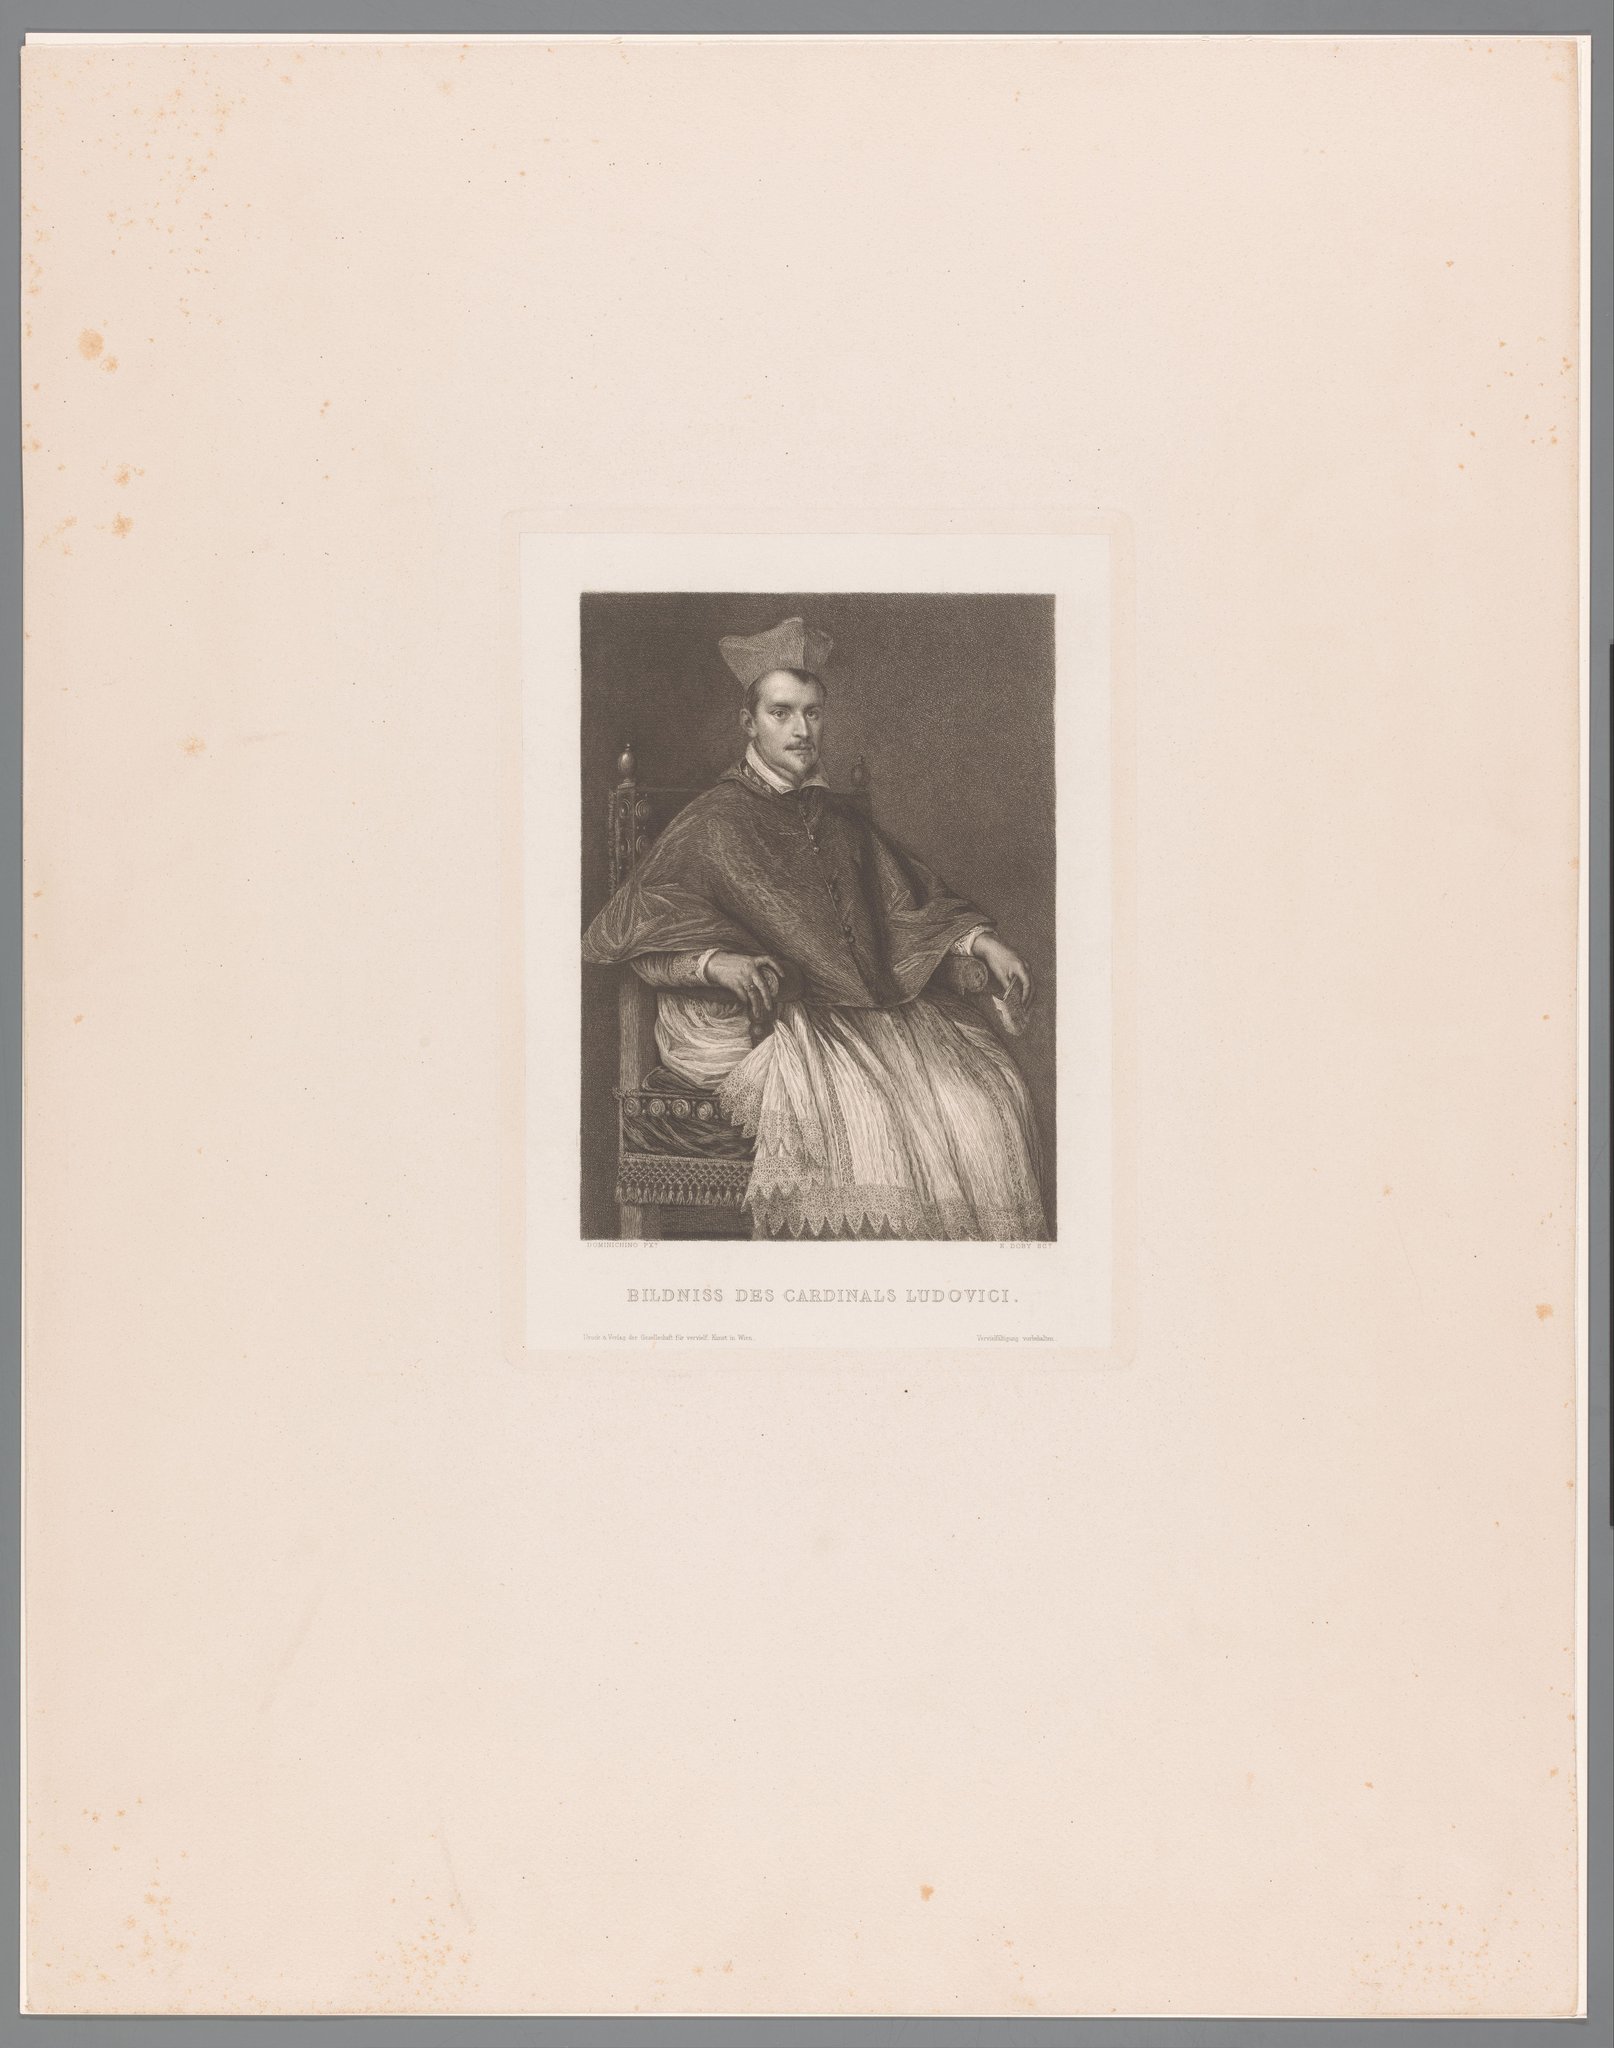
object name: print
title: Bildniss des Cardinals Ludovico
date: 1844-1907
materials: paper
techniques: etching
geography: vienna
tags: rome, cardinal, historical persons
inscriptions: collector's mark: Lugt 2228